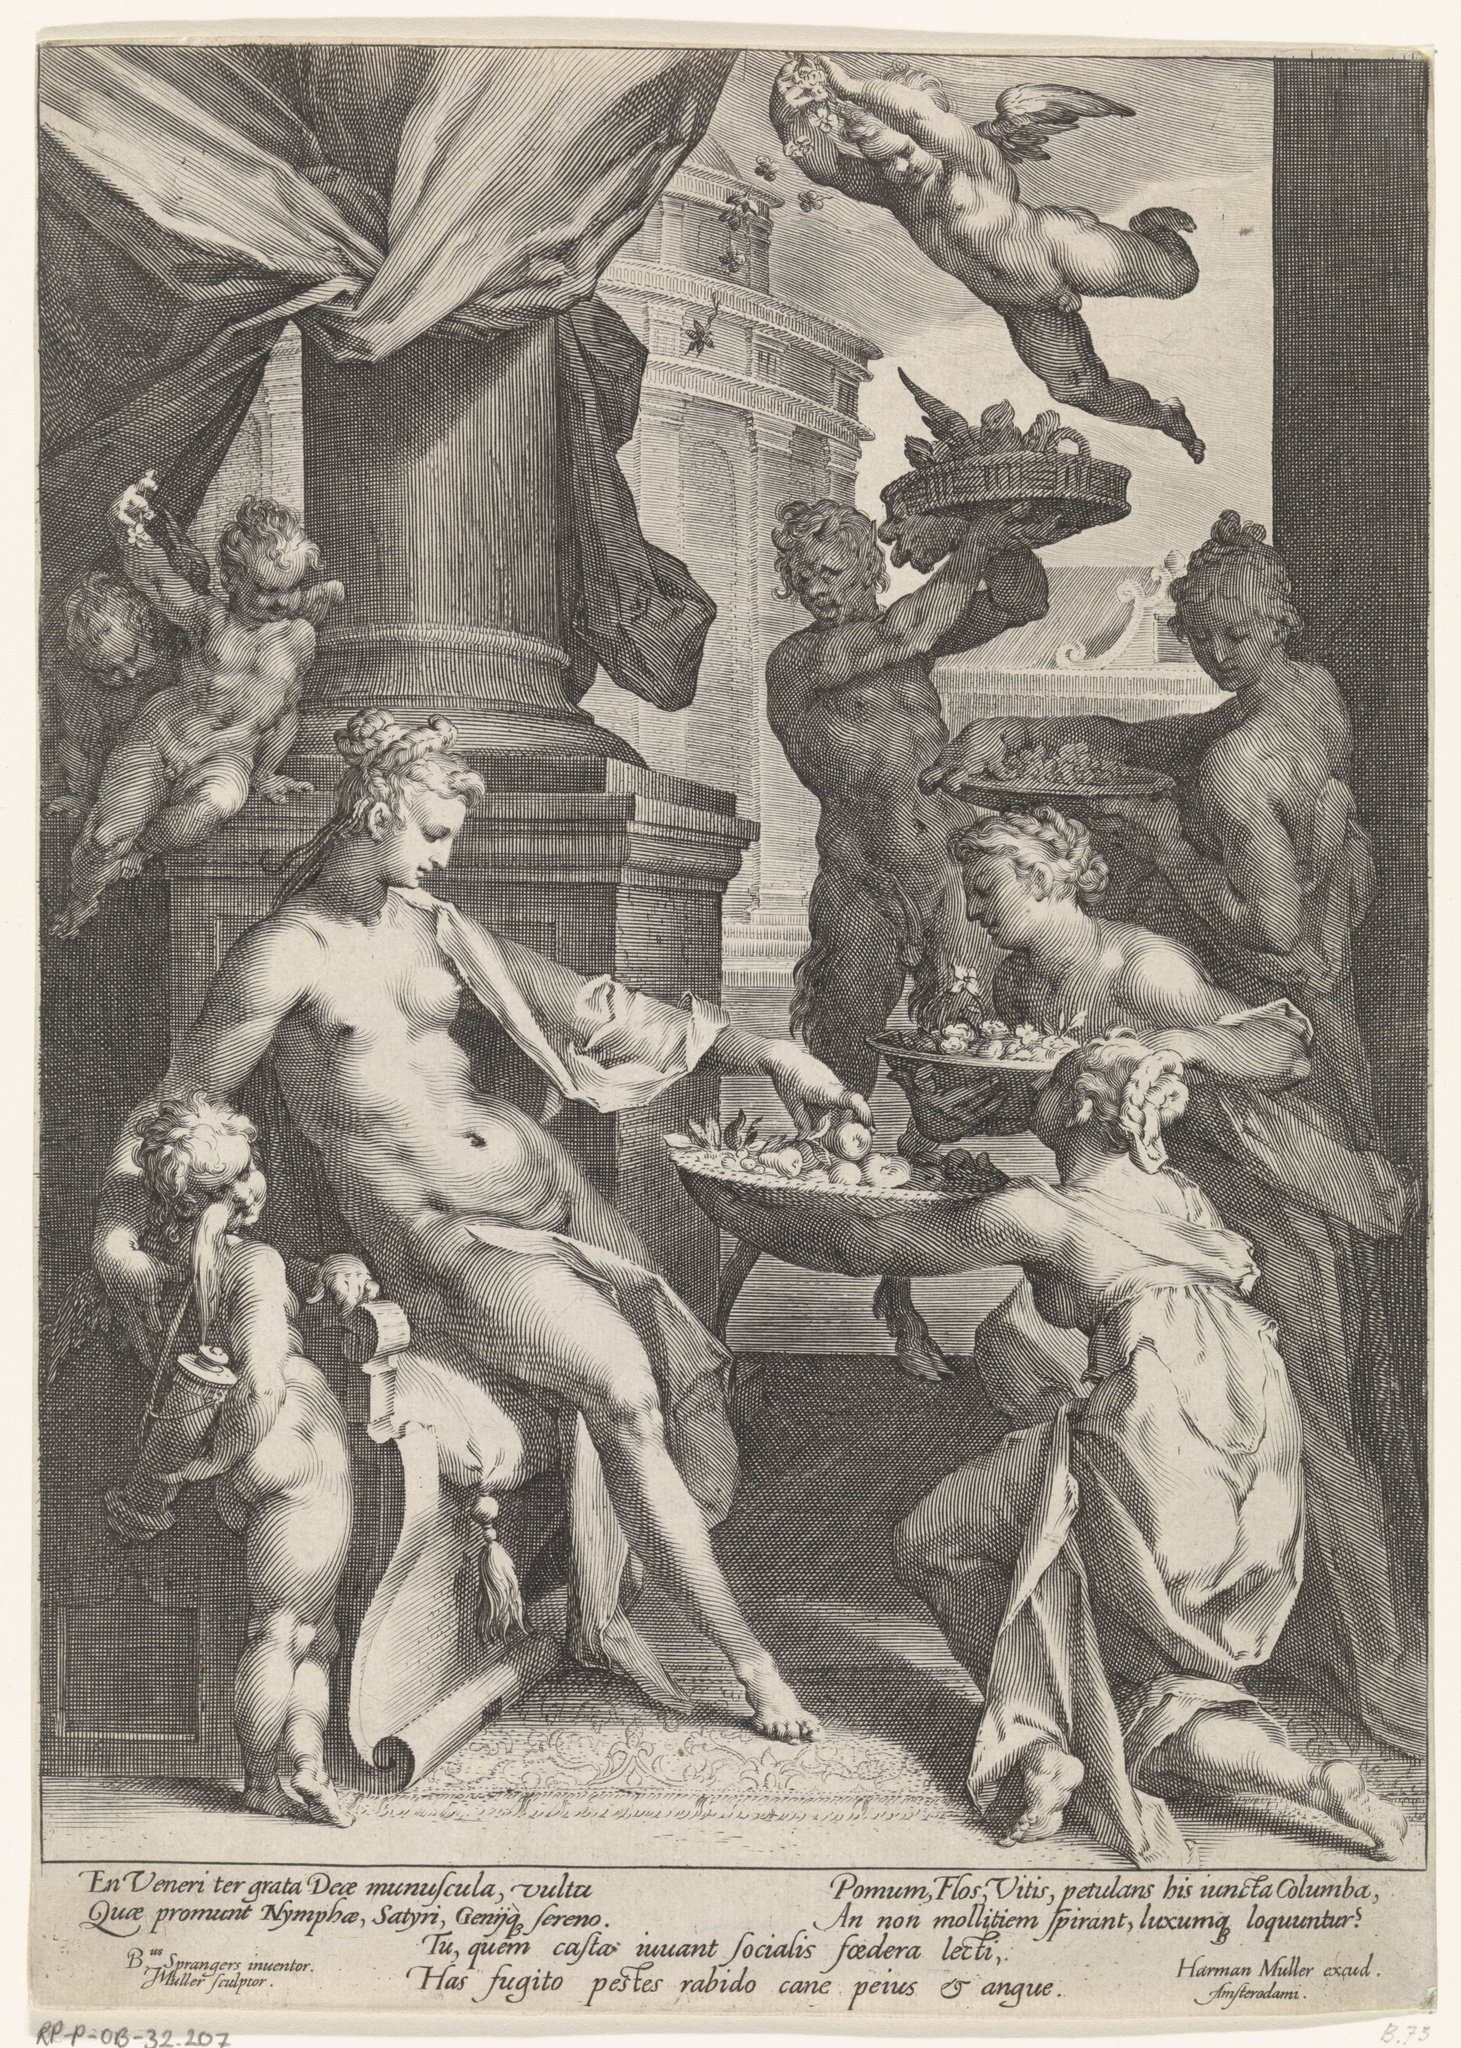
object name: print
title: Venus Honored by Nymphs and a Faun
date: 1589-1593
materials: paper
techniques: engraving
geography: amsterdam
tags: nymphs (in general); 'ninfe in commune' (ripa), veneration of venus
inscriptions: collector's mark: Lugt 2228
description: Venus, met Amor aan haar zijde, ontvangt manden met bloemen en vruchten van de nimfen. Een sater brengt een mand met gevogelte. Onderaan in de marge twee tweeregelige verzen in het Latijn.